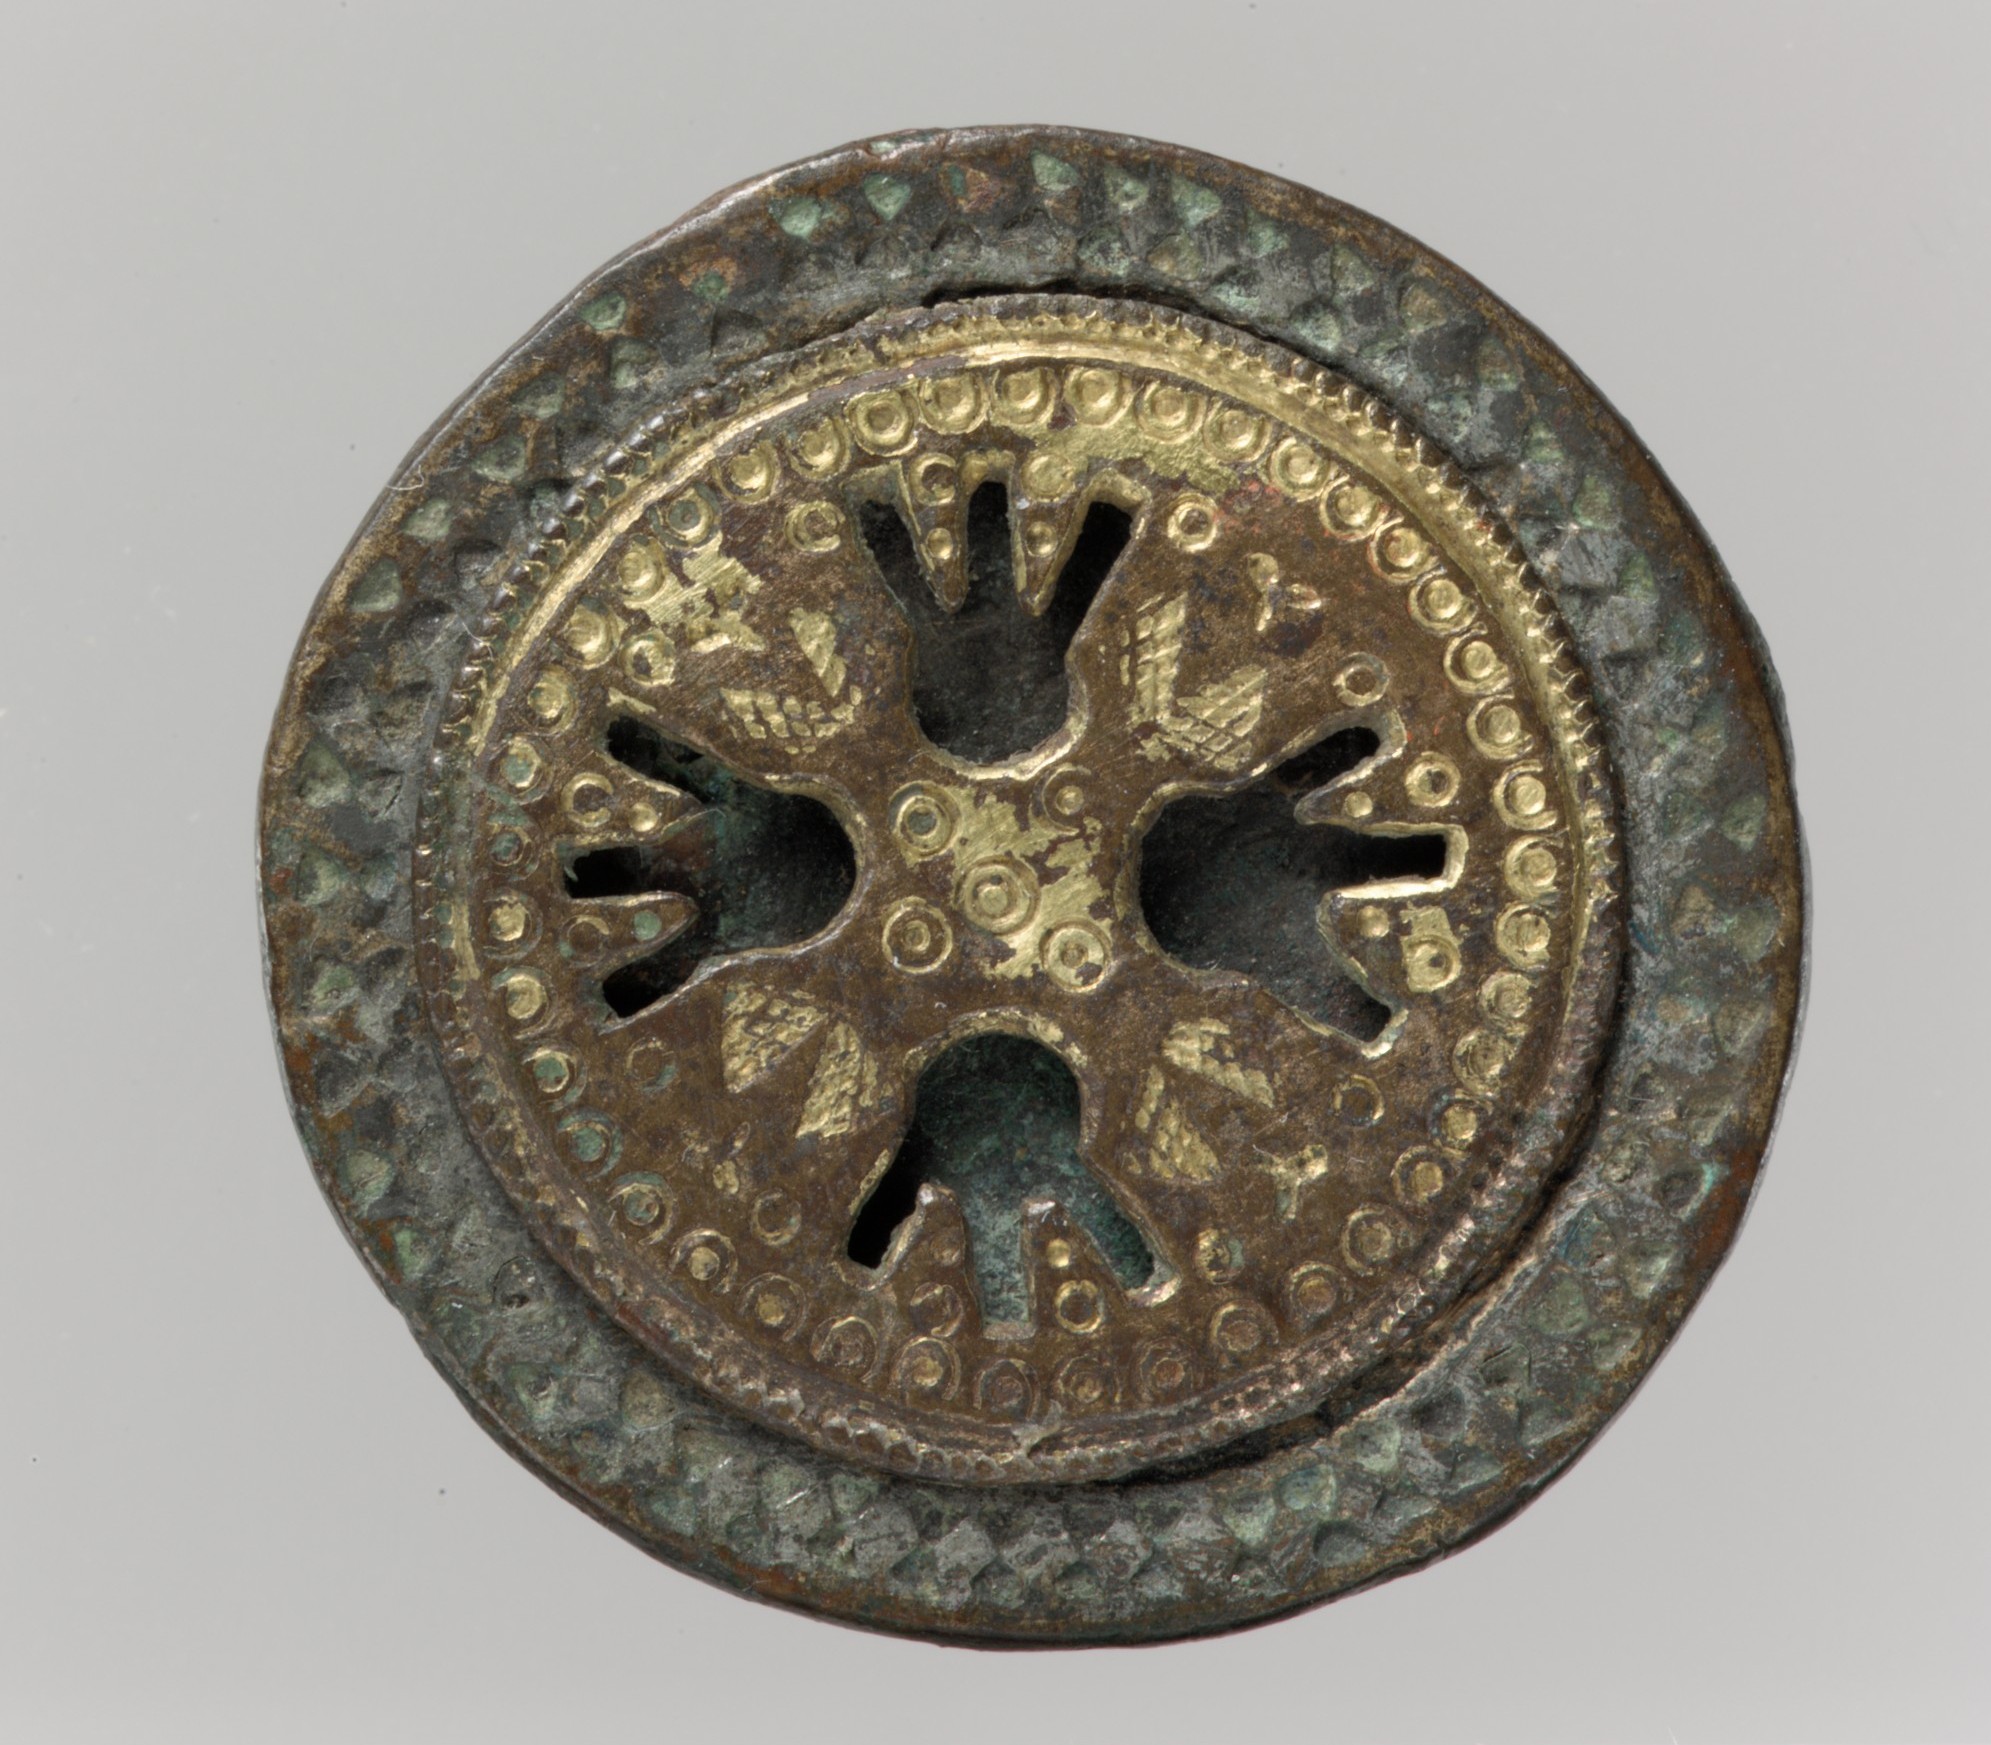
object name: brooch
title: Disk Brooch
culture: frankish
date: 501-600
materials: copper alloy, gilt, iron